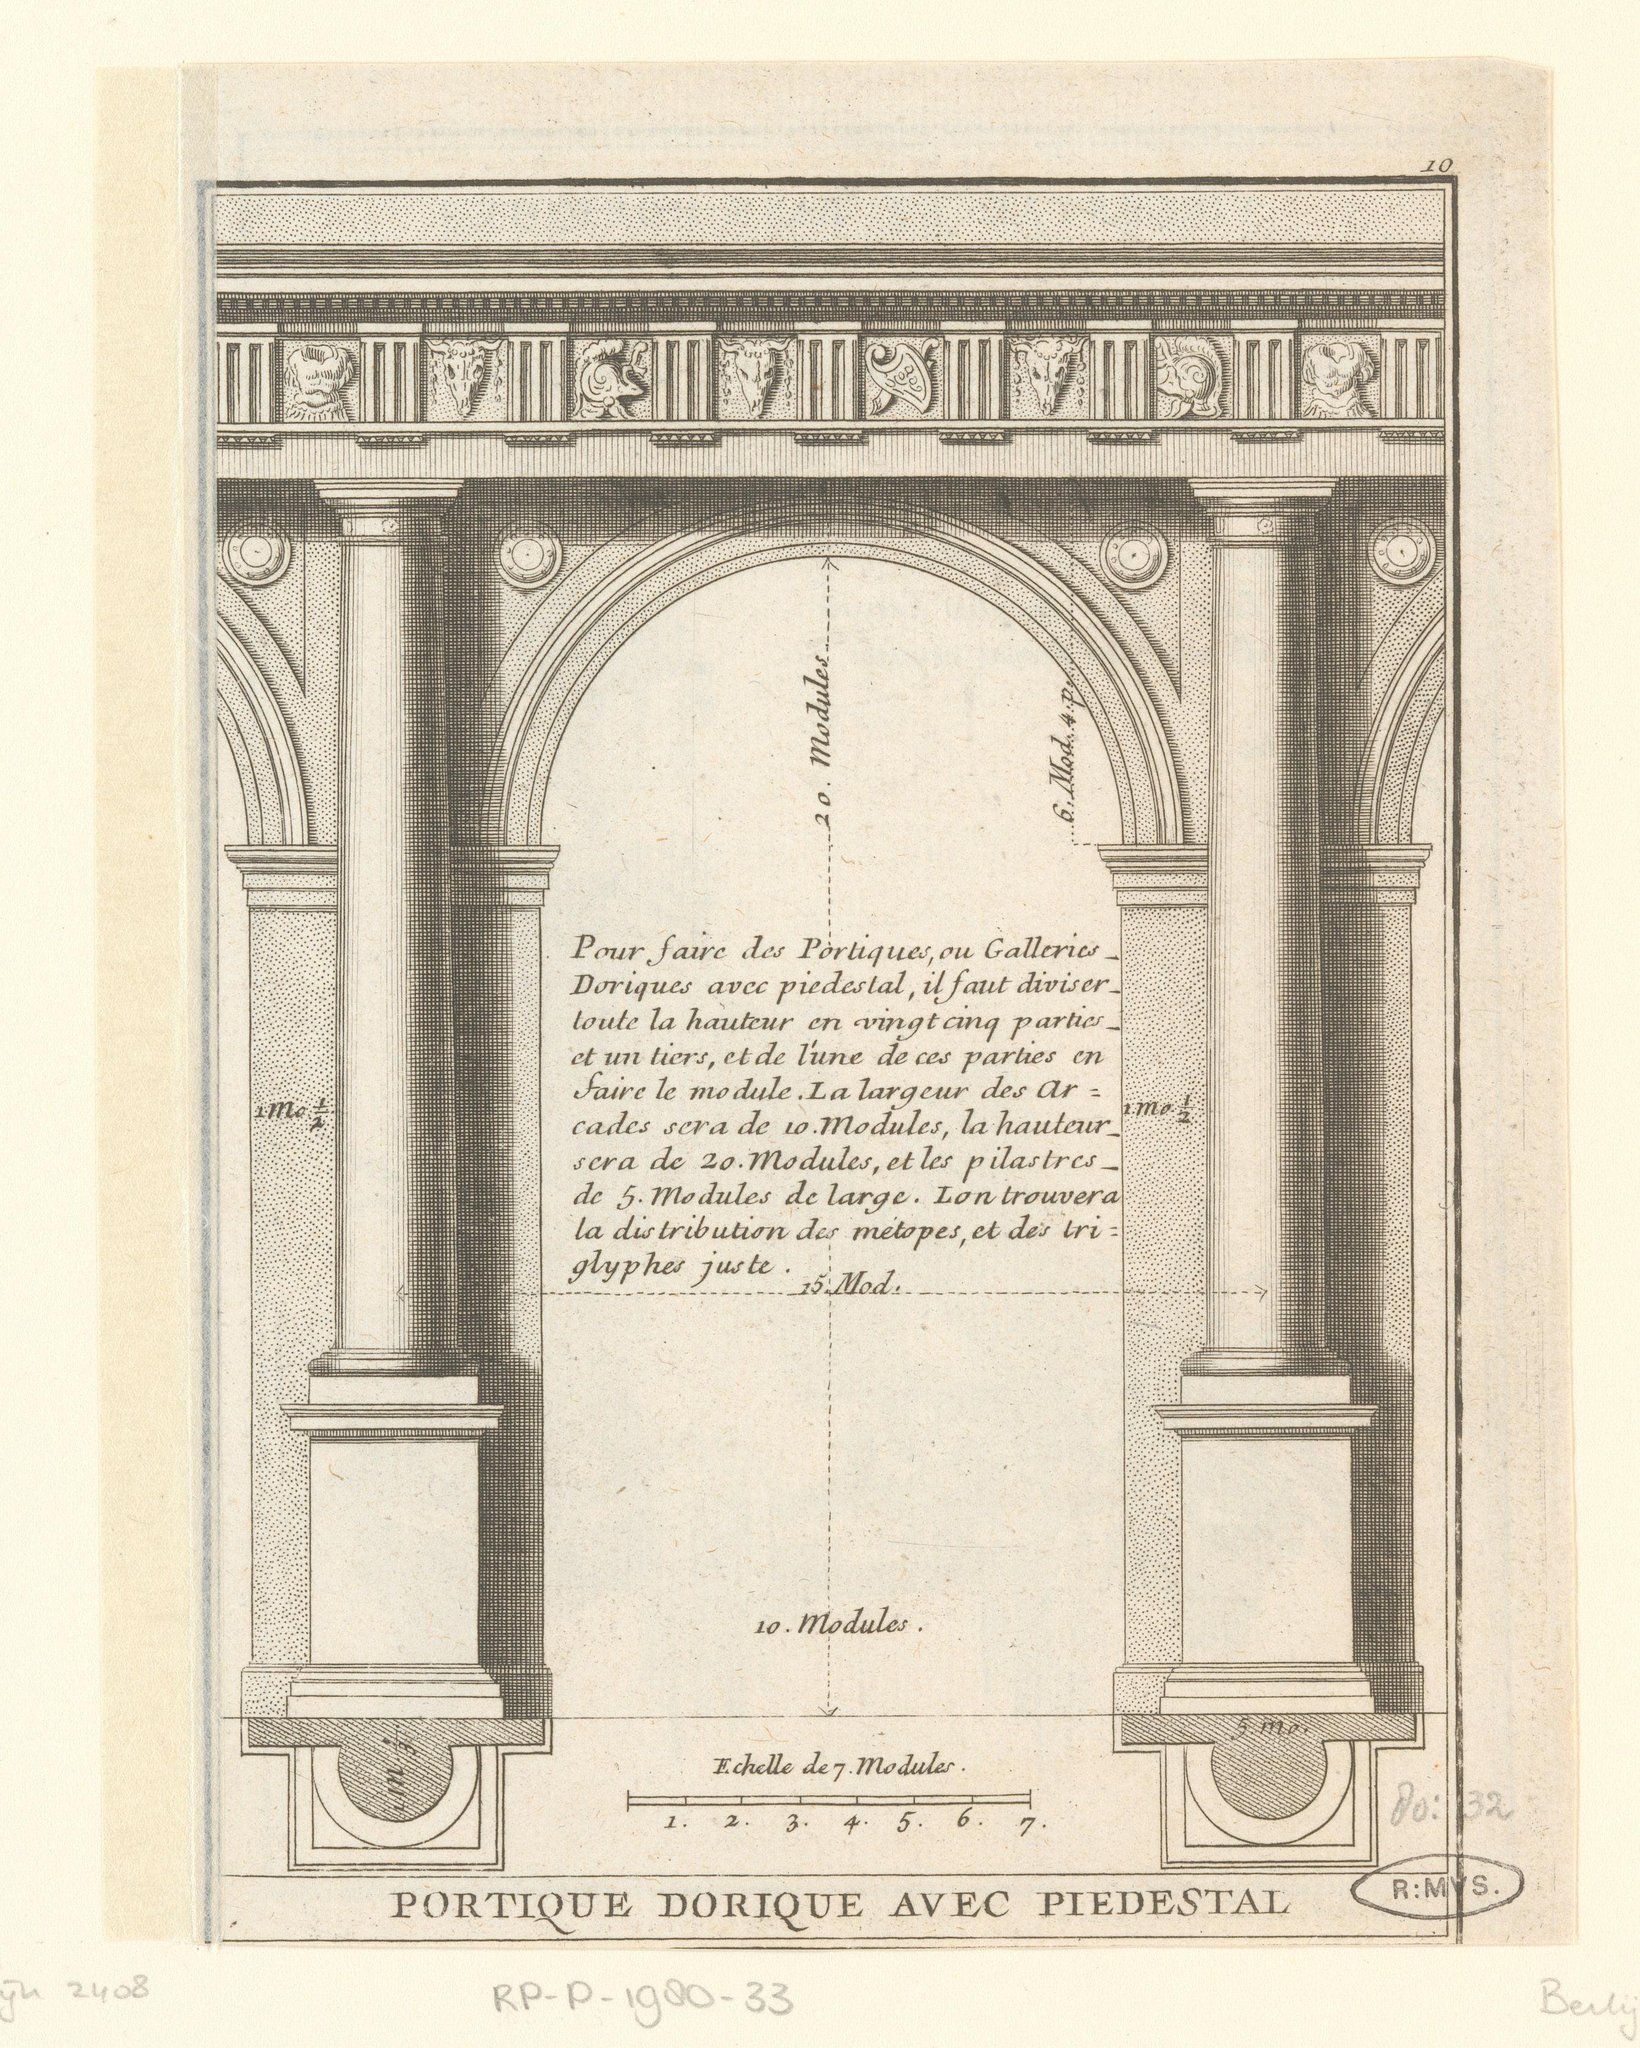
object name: ornament print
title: Le Nouveau Vignole ou Regles Des Cinq Ordres D'Architecture (...)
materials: paper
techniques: etching, letterpress printing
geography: paris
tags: monumental door, porch, 'aediculum', column, pillar ~ architecture, doric order ~ architecture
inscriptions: collector's mark: Lugt 2228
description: Pagina 10 uit: Babel, Pierre Edme. Le Nouveau Vignole ou Regles Des Cinq Ordres D'Architecture (...). Parijs: Chereau, François (II), 1755.